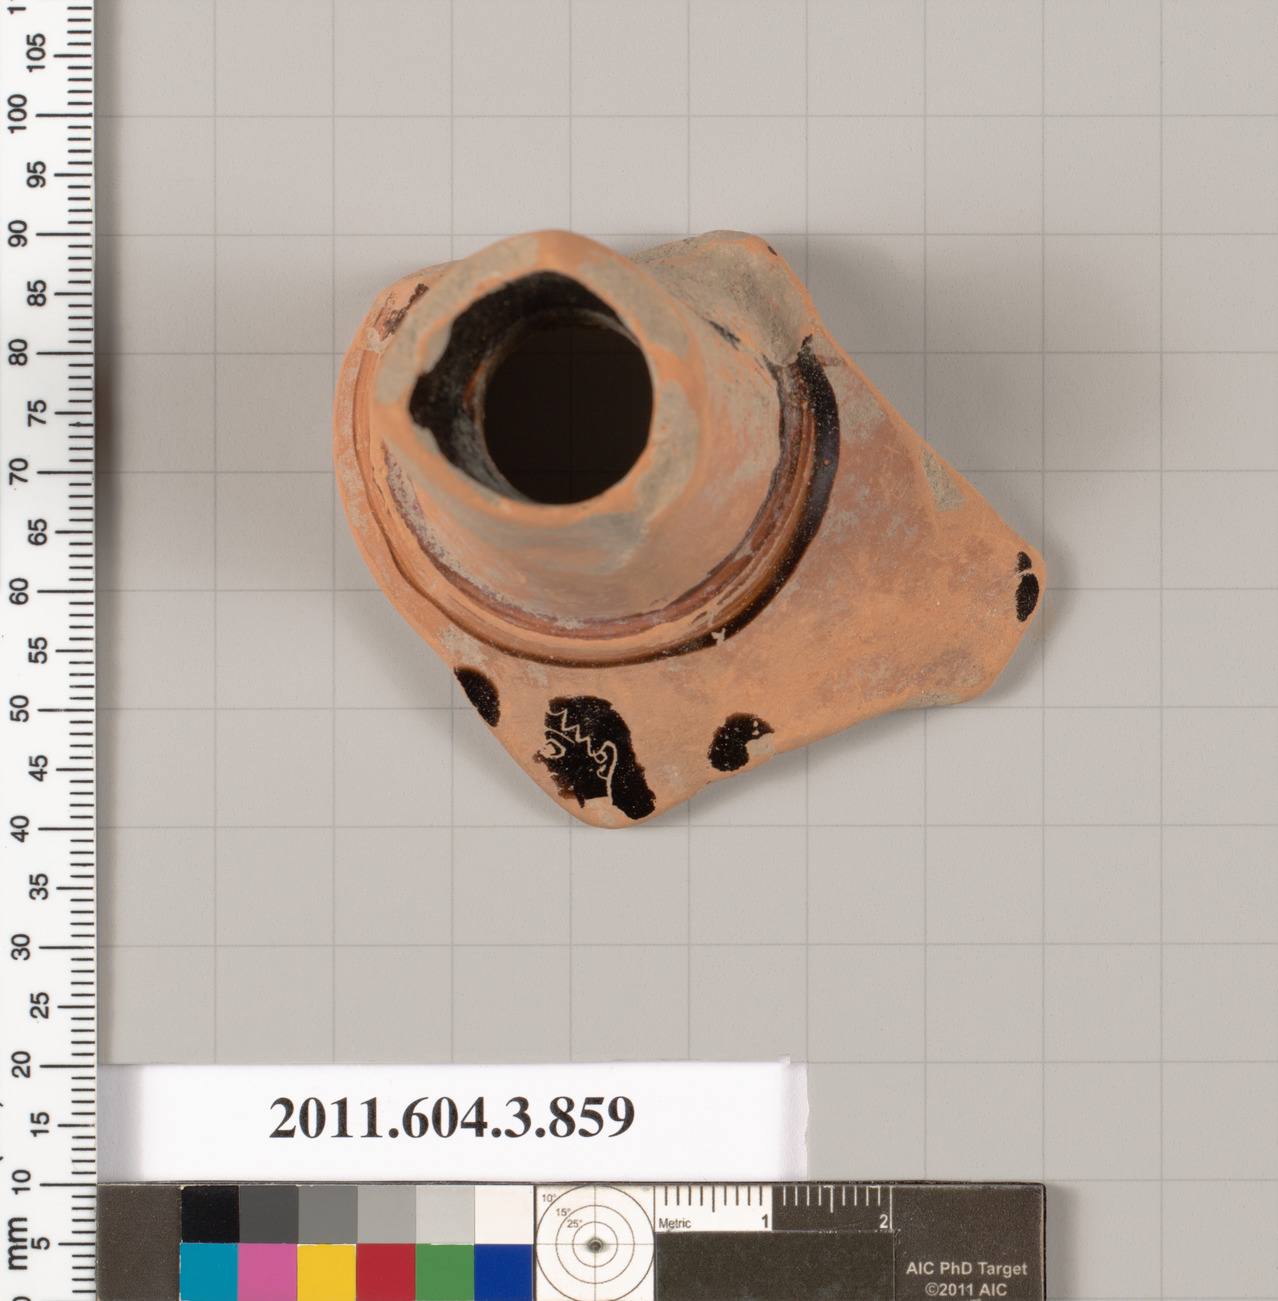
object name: lekythos fragment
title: Terracotta fragment of a lekythos (oil flask)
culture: greek, attic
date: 534-468 BCE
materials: terracotta